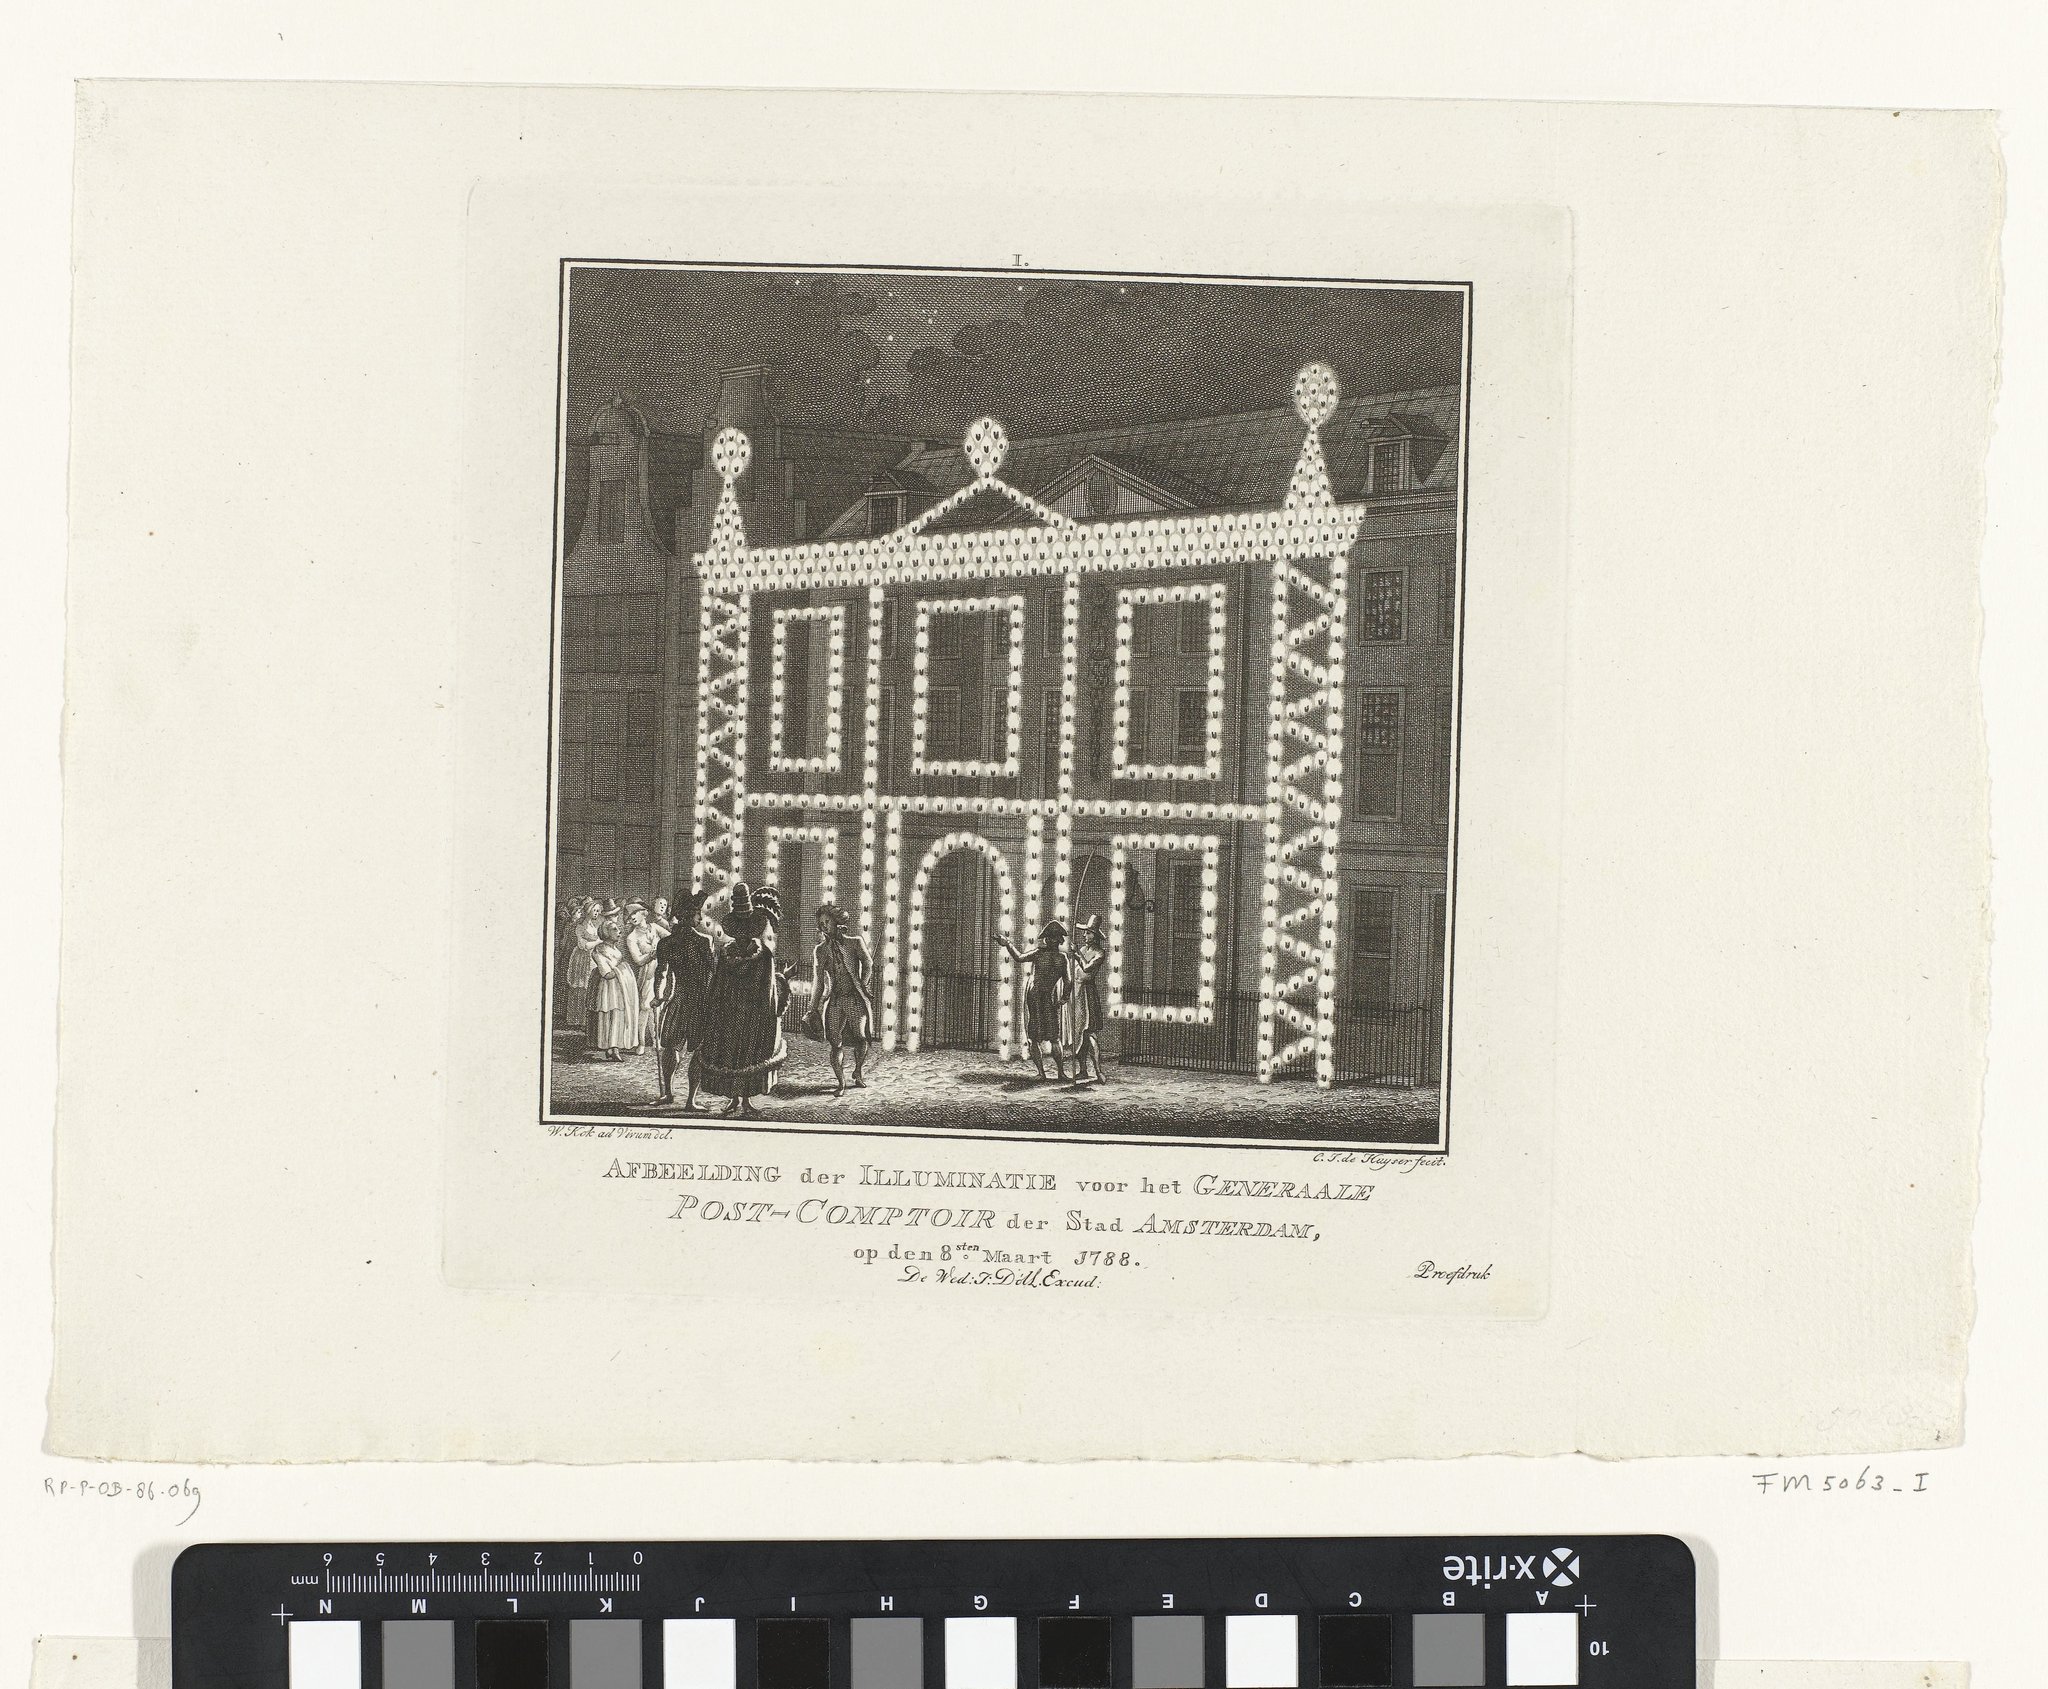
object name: print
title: Illuminatie van het Postkantoor te Amsterdam, 1788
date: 1788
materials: paper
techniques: engraving, etching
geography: amsterdam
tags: william v (prince of orange), bonfire, fire-works (+ illumination, fire-works ~ festive activities)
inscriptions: collector's mark: Lugt 2228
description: Illuminatie van het Postkantoor op het Nieuwezijds Voorburgwal te Amsterdam. Genummerd bovenaan: I. Onderdeel van een reeks van twaalf platen van de illuminaties en decoraties te Amsterdam op de 40ste verjaardag van prins Willem V op 8 maart 1788.